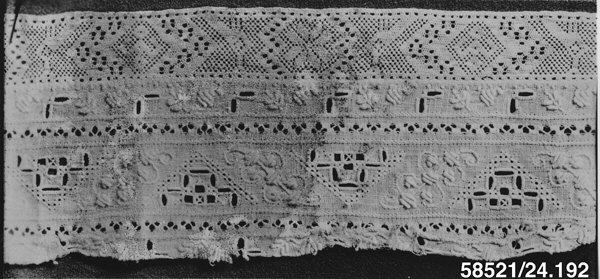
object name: strip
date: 1601-1633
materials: linen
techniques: embroidery